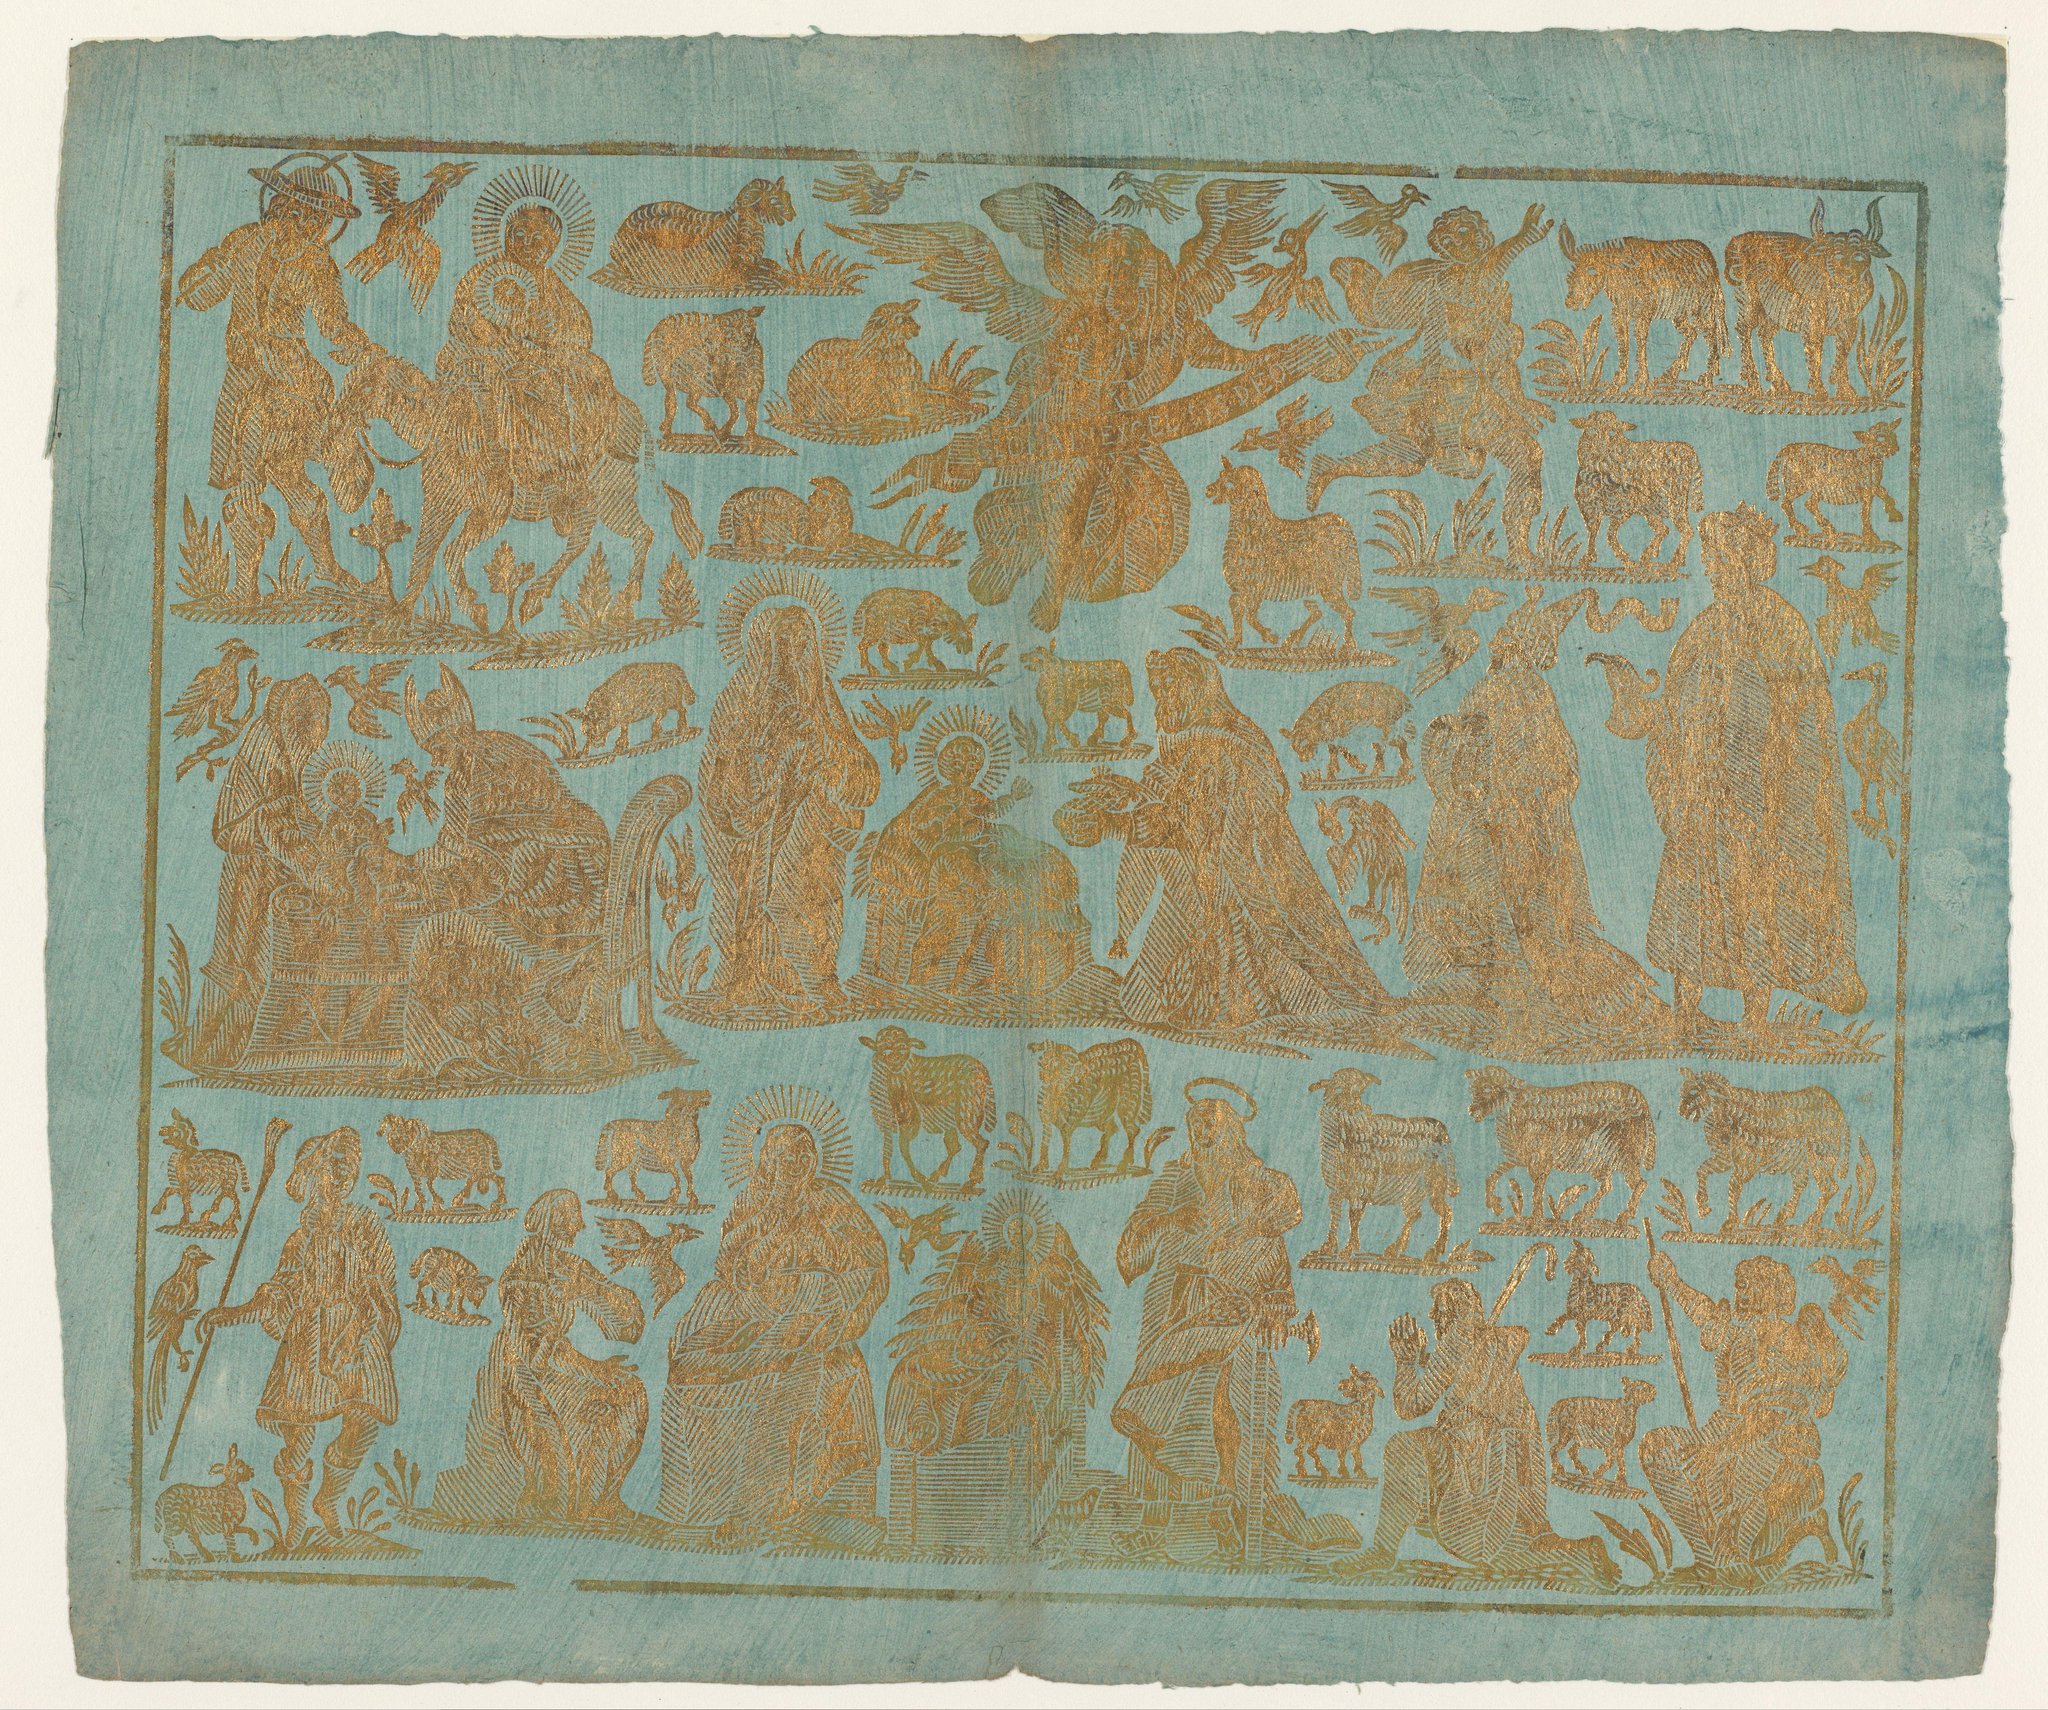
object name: brocade paper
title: Blad met scènes rond de geboorte van Christus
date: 1750-1800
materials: gold leaf, paint, paper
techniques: relief print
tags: birth and youth of christ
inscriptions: collector's mark: Lugt 2228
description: Blad met scènes rond de geboorte van Christus. Middenboven de Engel der Verkondiging, linksboven de vlucht naar Egypte, rechtsboven runderen, linksonder staande herder met schapen, rechtsonder knielende herders.